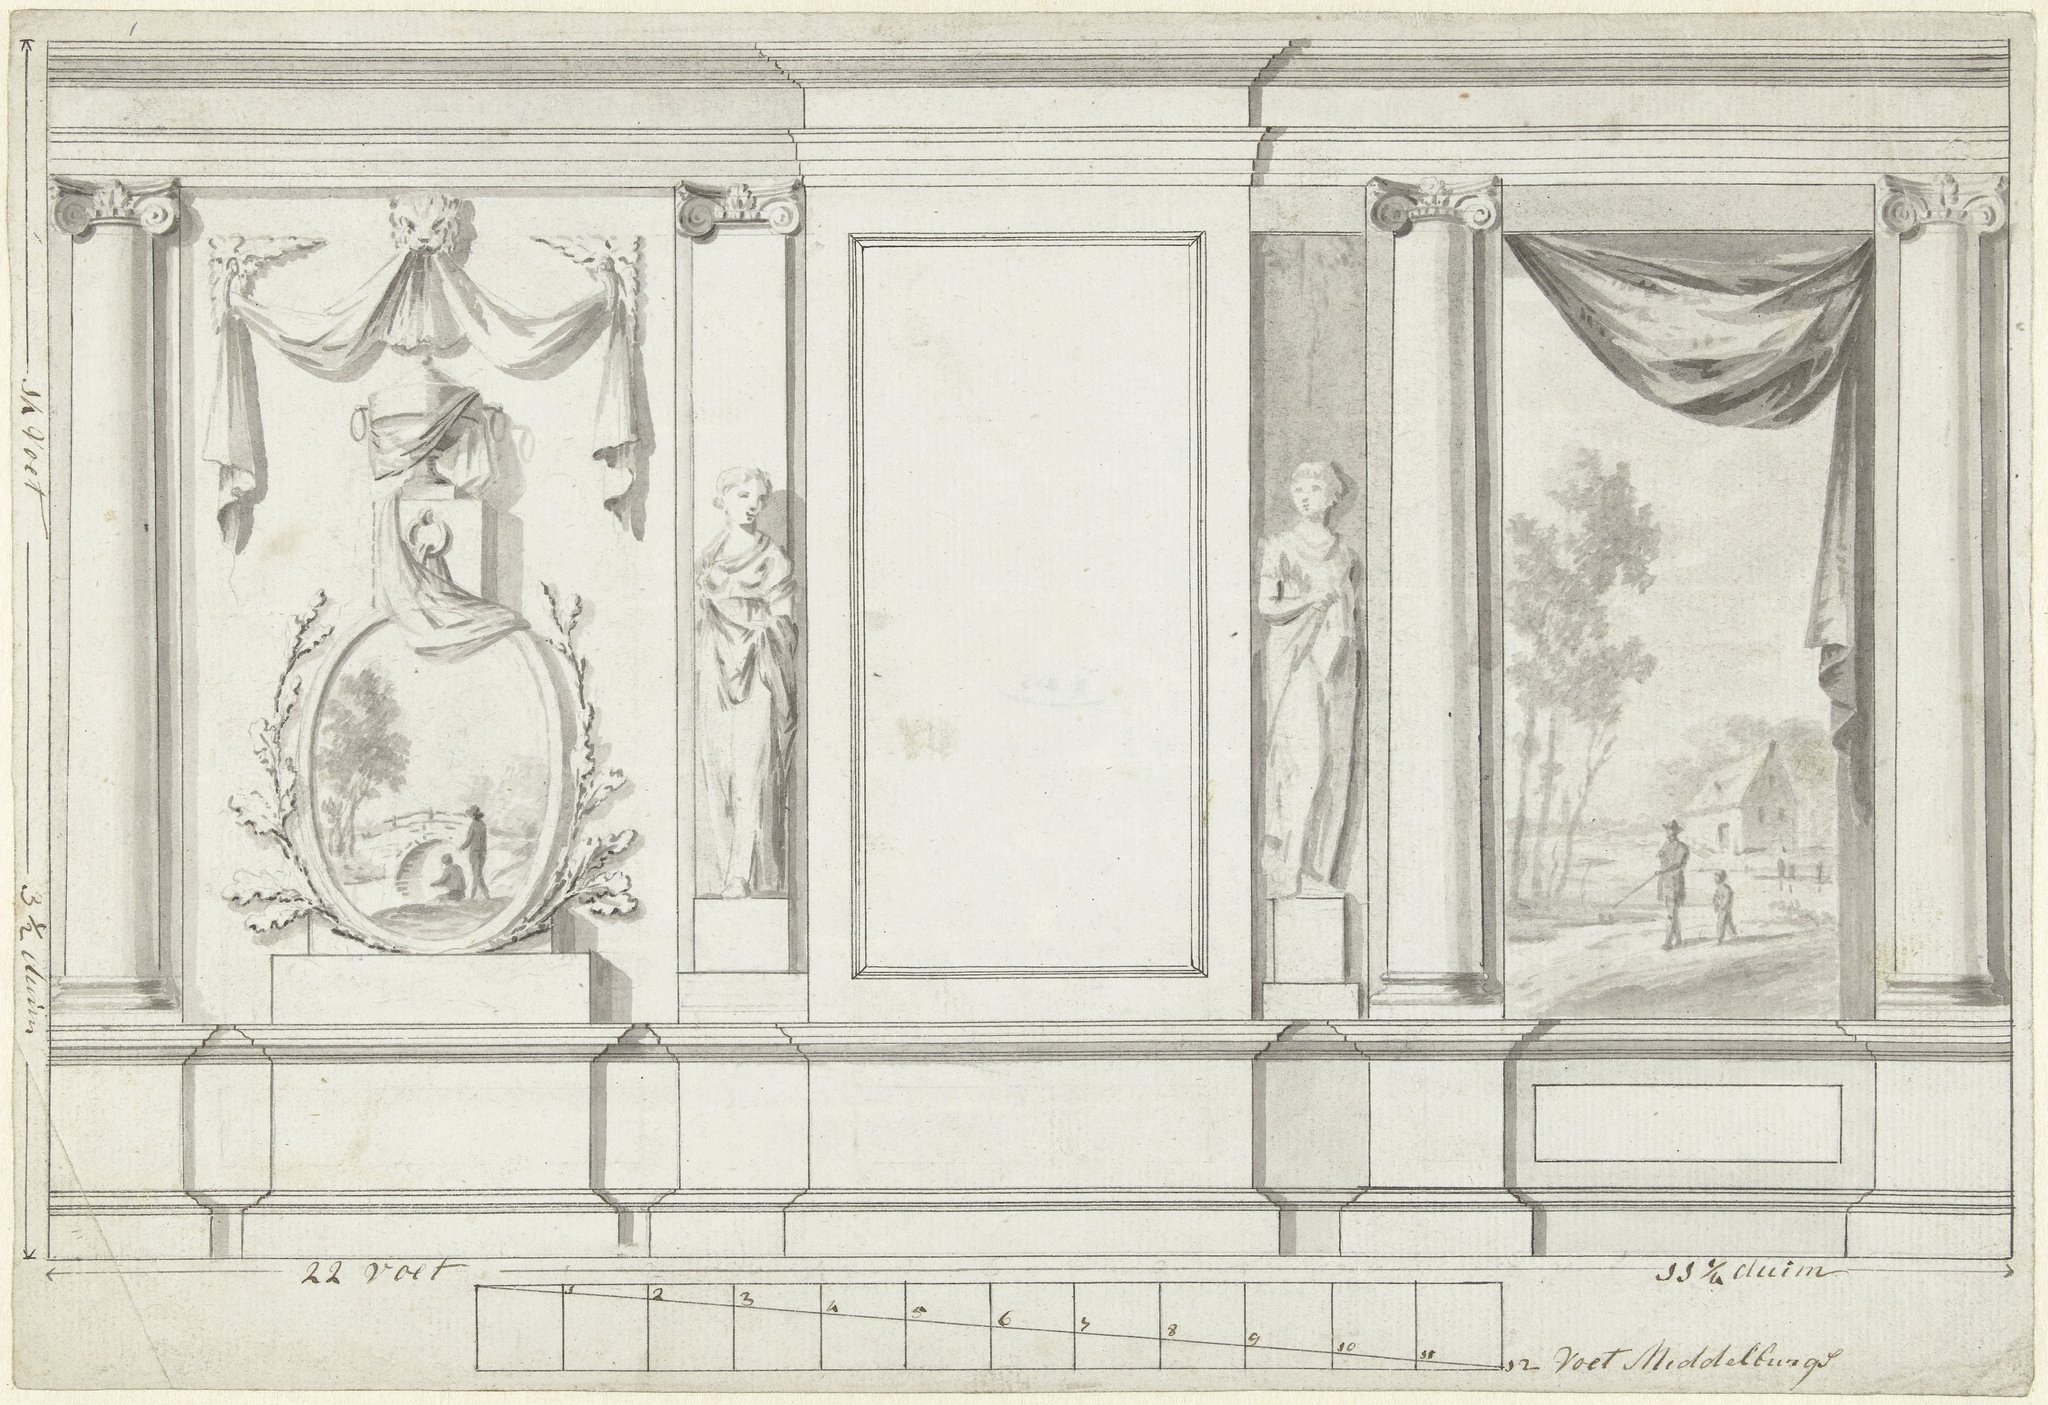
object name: design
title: Ontwerp voor kamerversiering met twee panelen met landschappen geflankeerd door een standbeeld van een vrouw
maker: abraham meertens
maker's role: draughtsman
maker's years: 1757-1823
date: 1767-1823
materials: ink, paper, pencil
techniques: brush, pen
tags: wall-covering